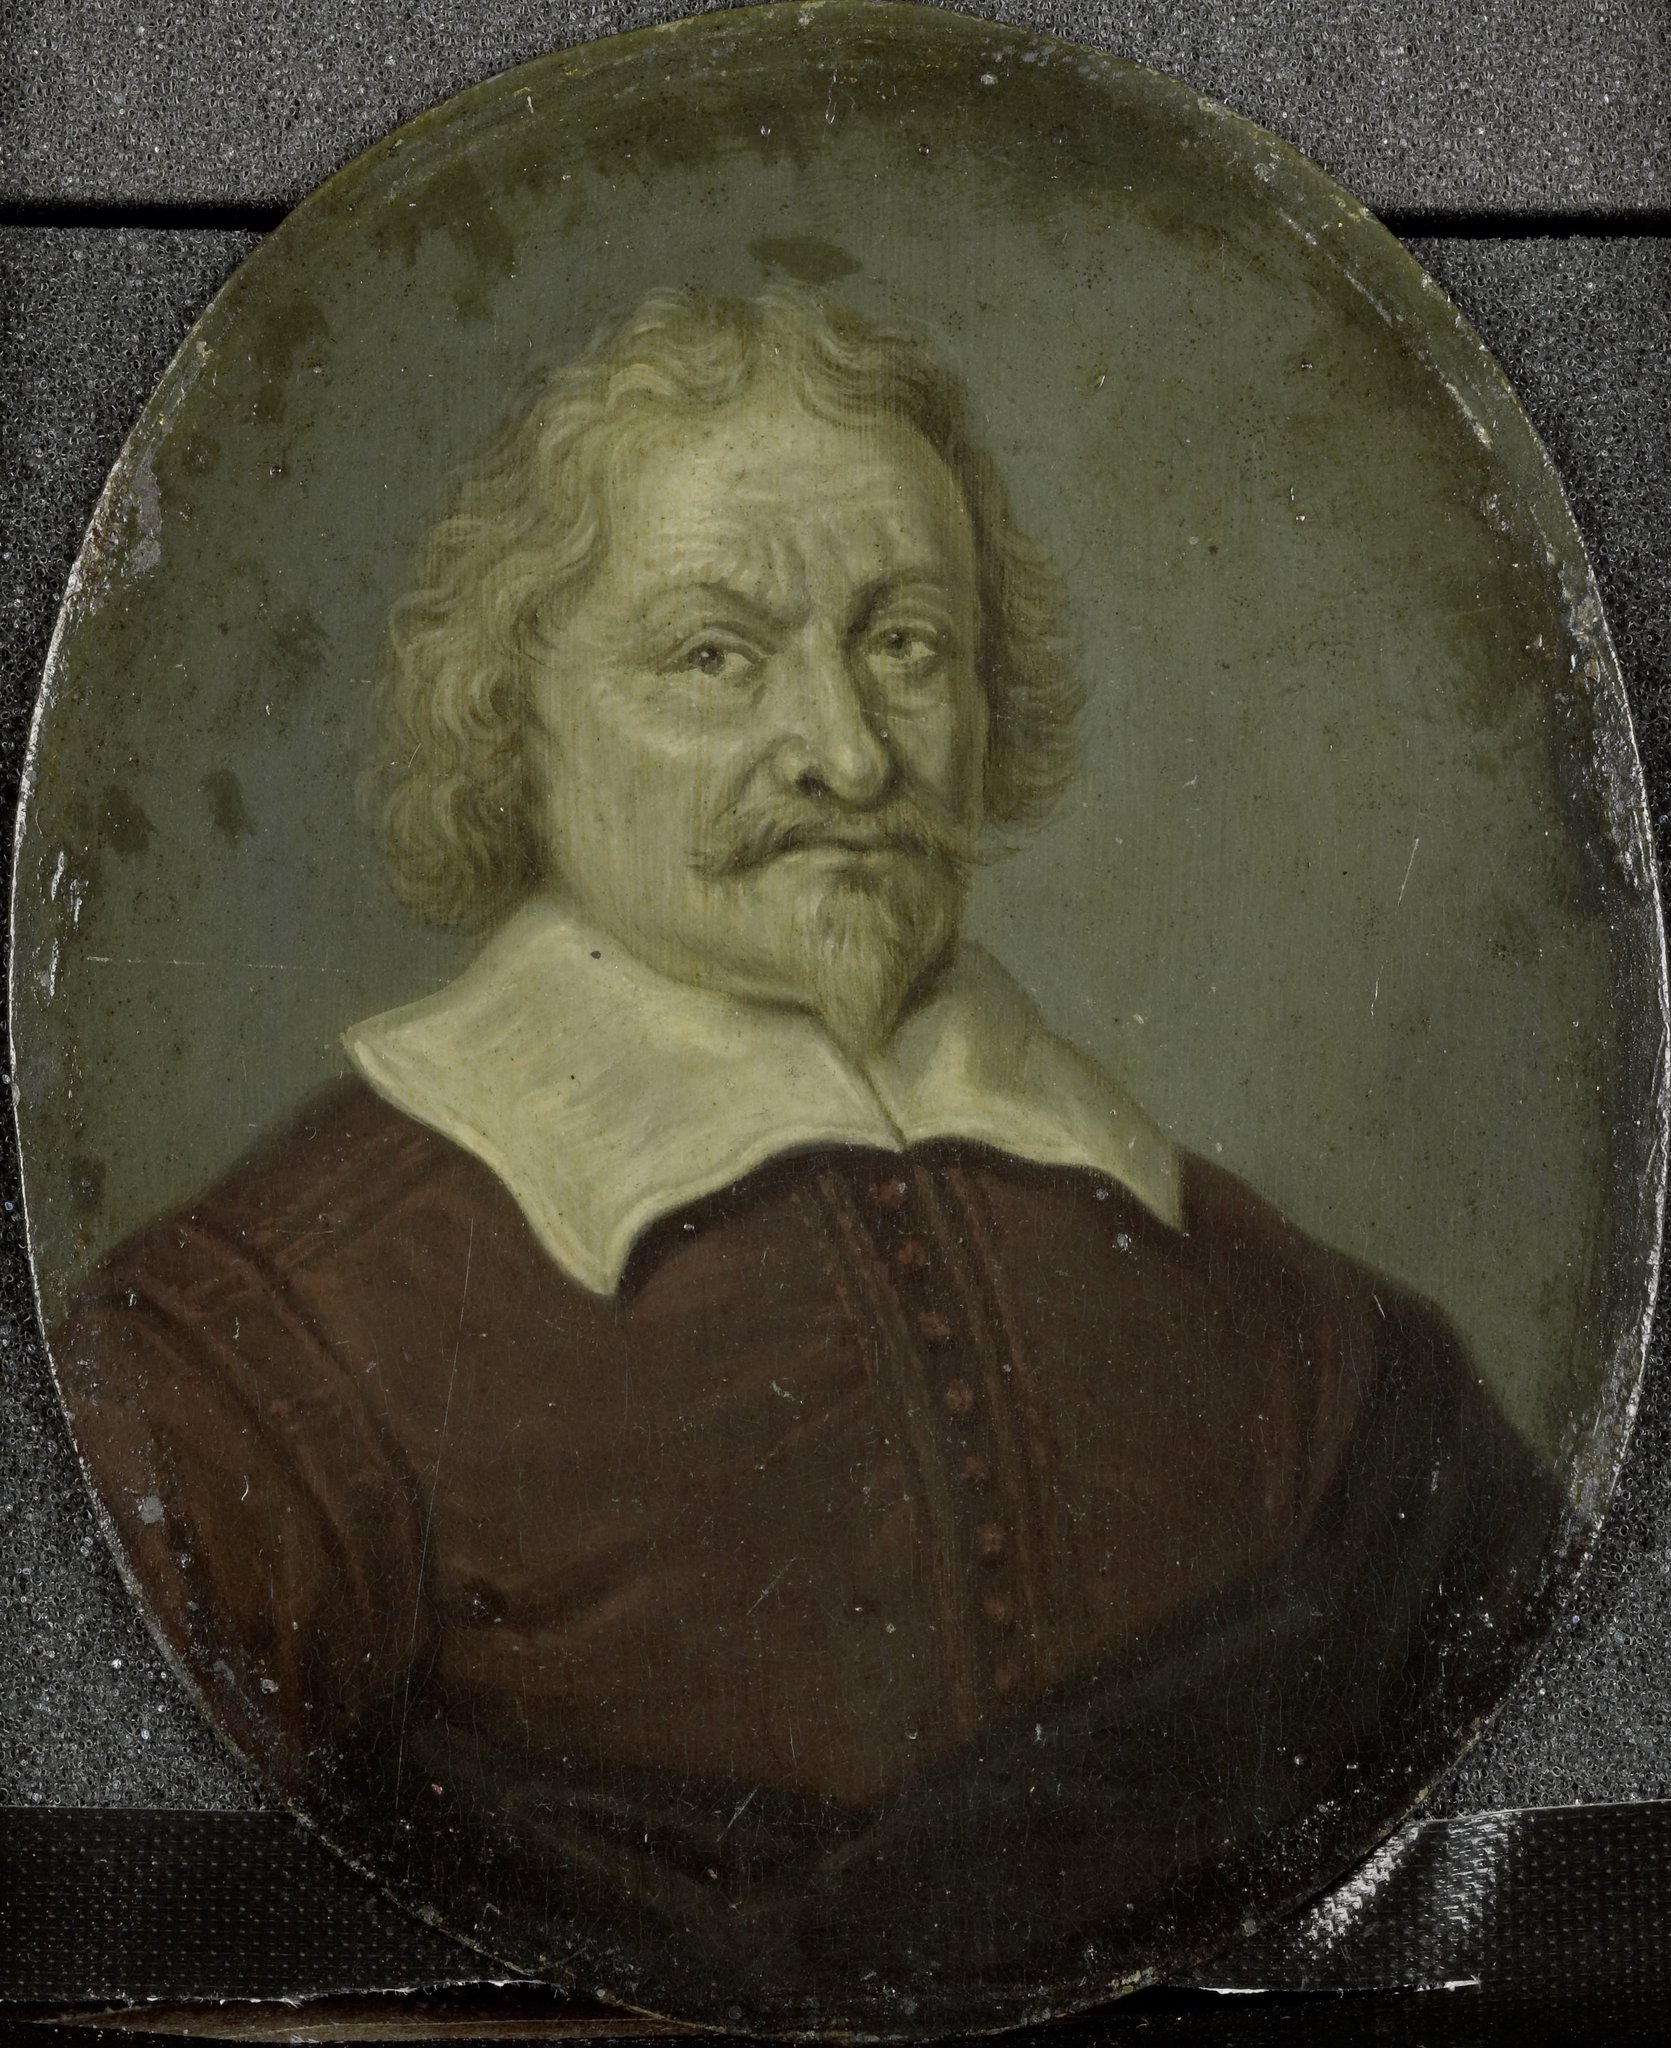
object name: grisaille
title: Portrait of David or Daniel Lingelbach I, Founder of the Nieuwe Doolhof (New Labyringh), Amsterdam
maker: arnoud van halen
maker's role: draughtsman, painter, print maker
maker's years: 1673-1732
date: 1700-1732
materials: oil, metal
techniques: grisaille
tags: amsterdam, portrait of a writer, writer, poet, author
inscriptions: inscription: ‘Daniel Lingelbach. Circa 1625’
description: Portret van David of Daniël Lingelbach I (1592/93-1653). Oprichter van de Nieuwe Doolhof, Amsterdam. Buste in ovaal, naar rechts. Onderdeel van een verzameling portretten van Nederlandse dichters.